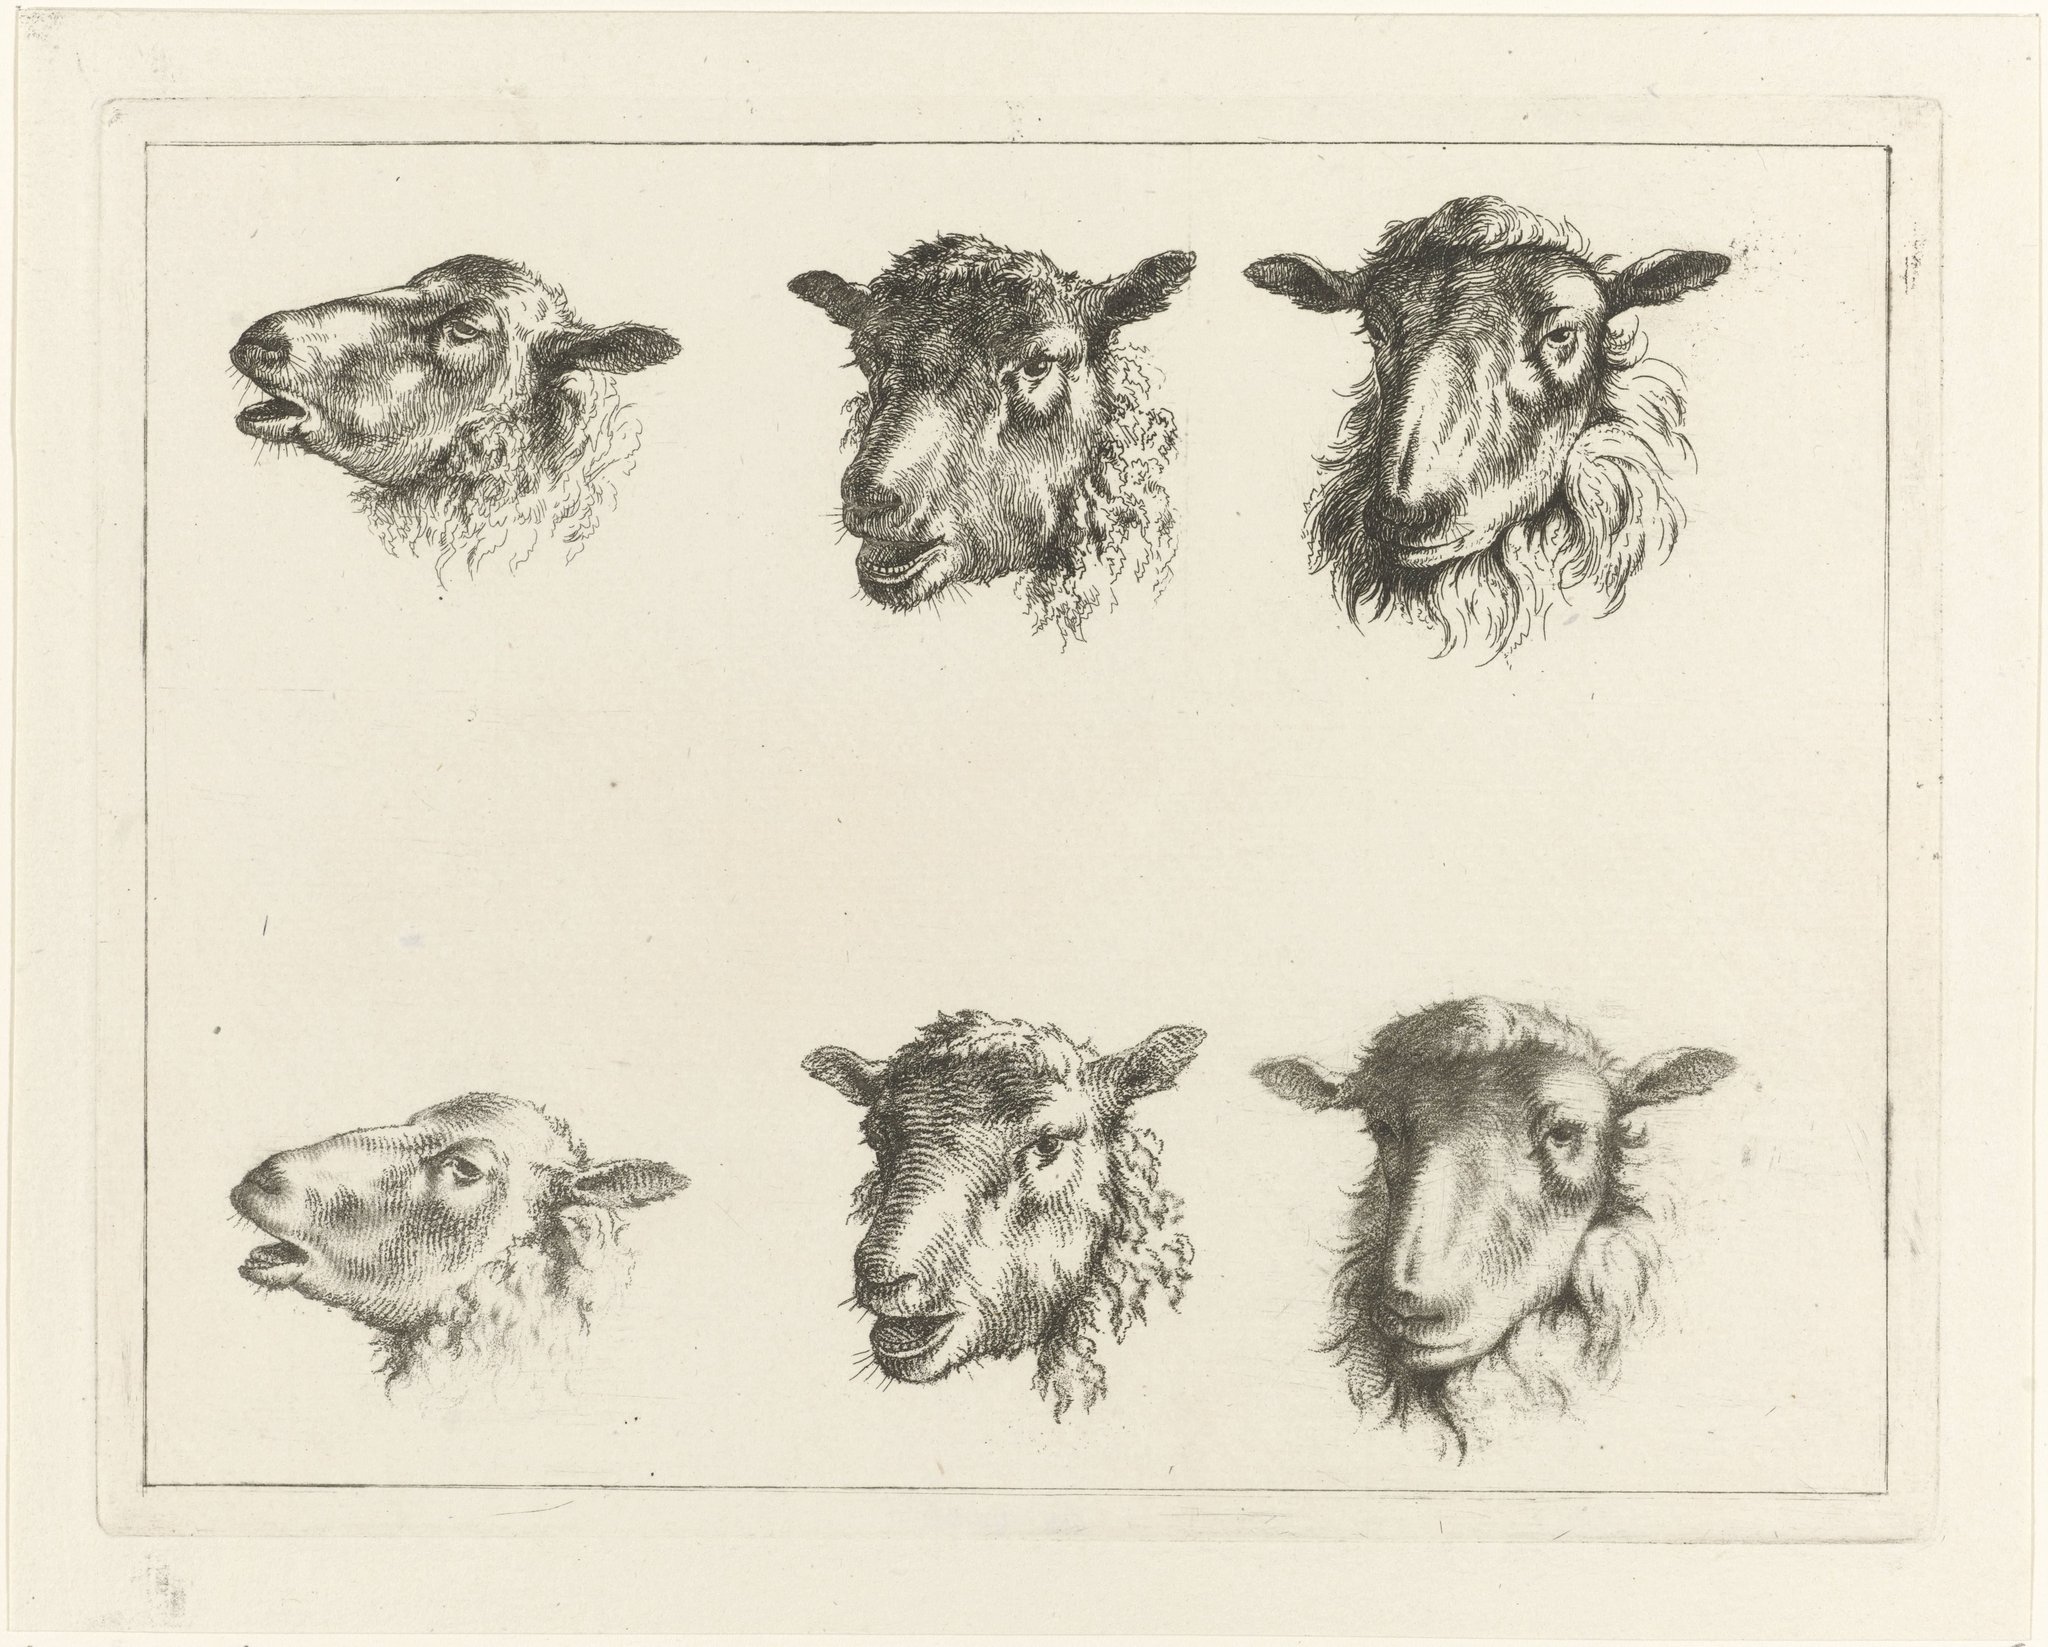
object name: print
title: Studieblad met zes schapenkoppen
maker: johannes janson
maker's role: draughtsman, painter, print maker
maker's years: 1729-1784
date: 1761-1784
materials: paper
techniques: etching, soft ground etching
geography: leiden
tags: sheep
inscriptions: collector's mark: Lugt 2228